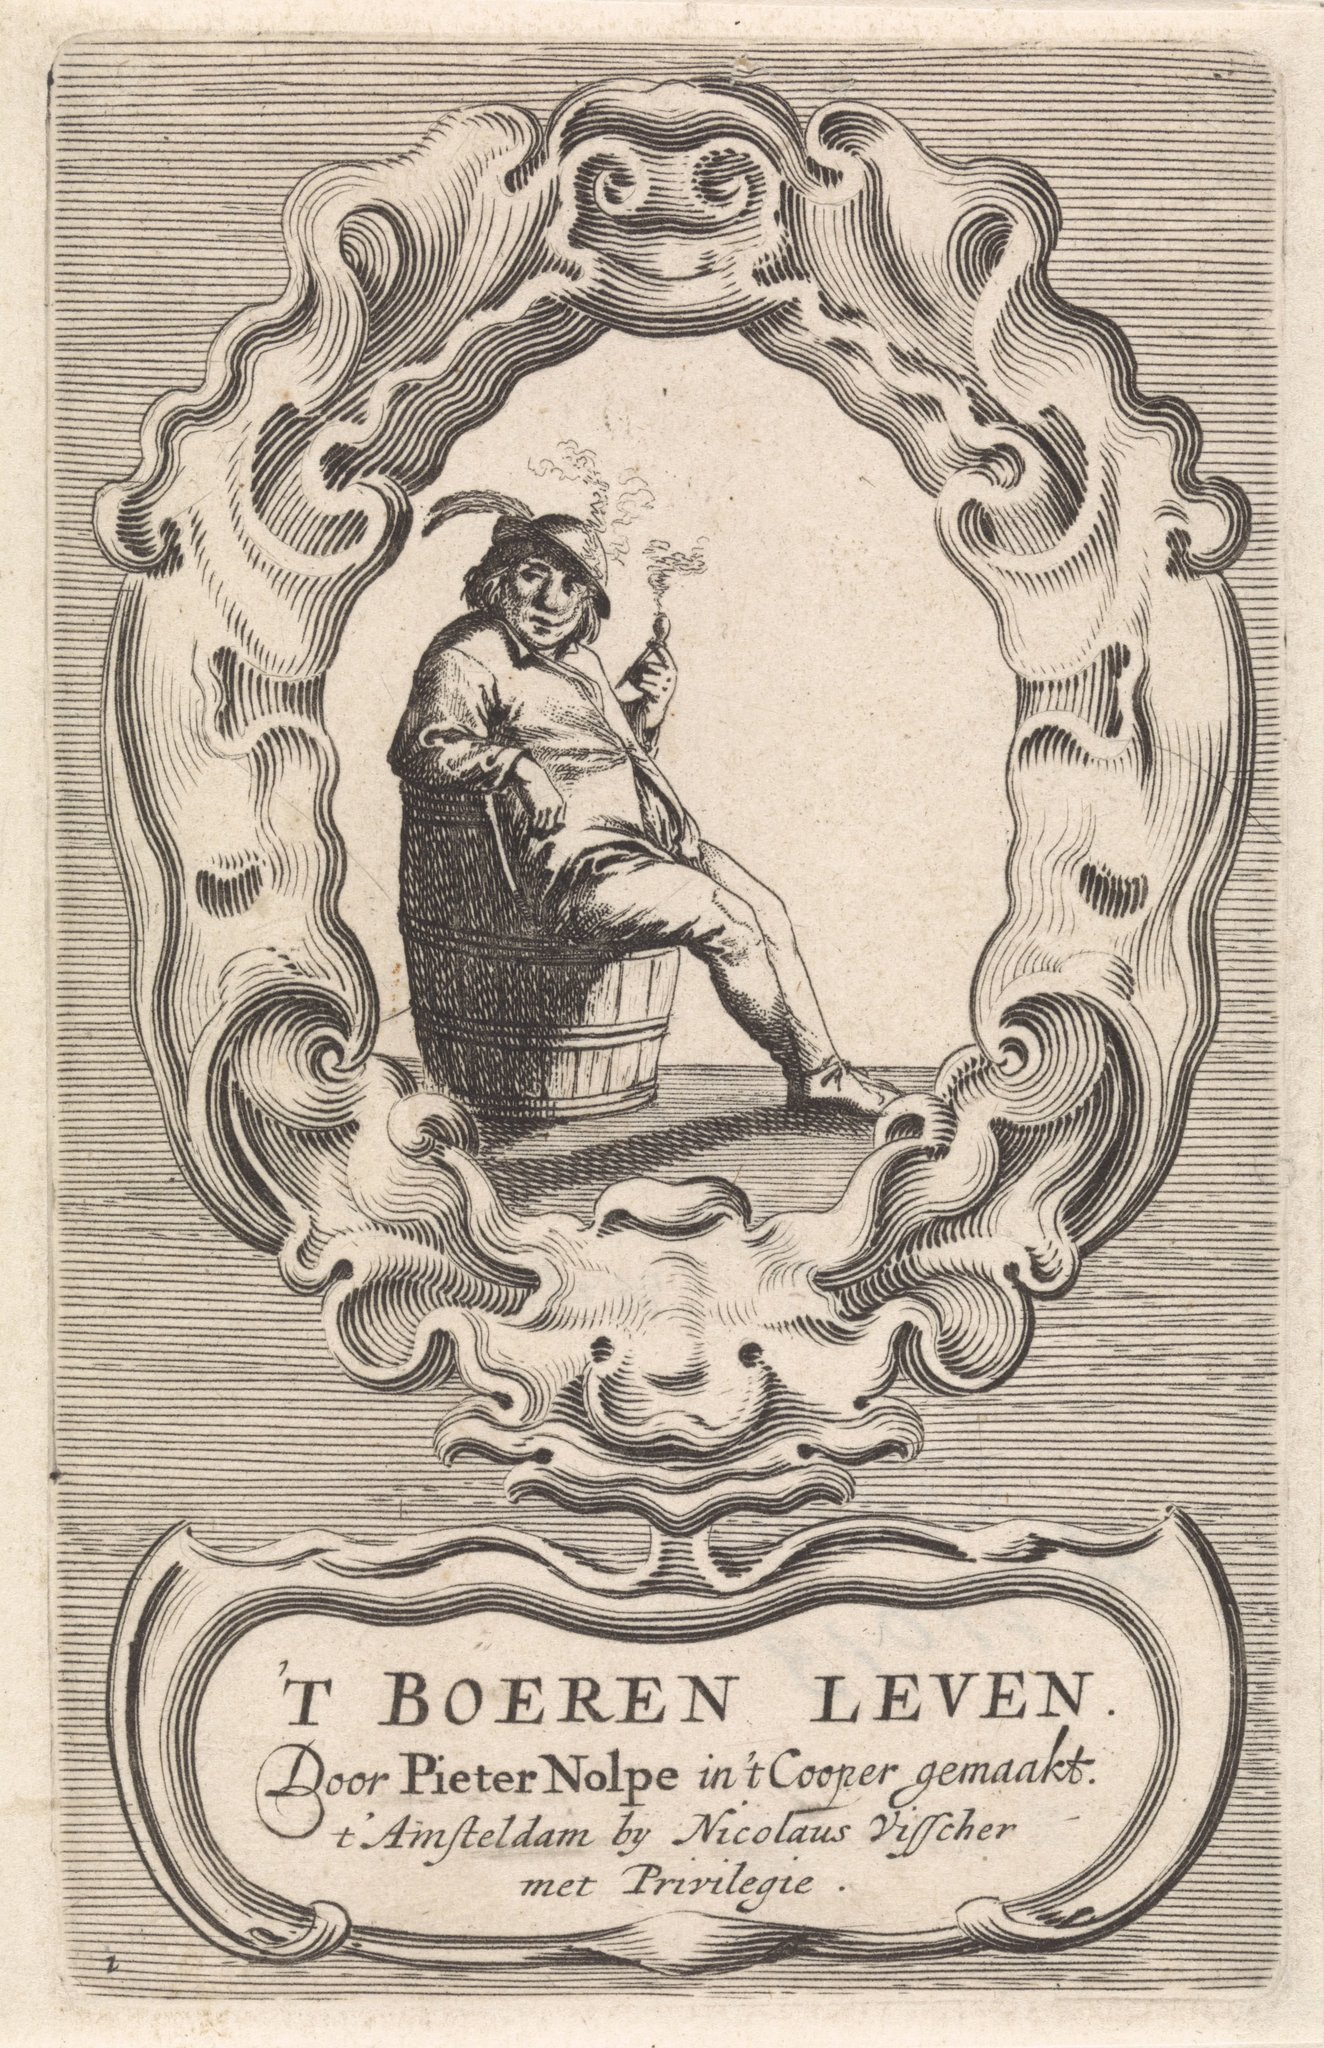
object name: print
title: Zittende pijprokende boer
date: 1633-1679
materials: paper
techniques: engraving, etching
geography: amsterdam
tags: wooden container: barrel, cask, bucket, pipe ~ tobacco, farmers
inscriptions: collector's mark: Lugt 2228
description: Een boer zit in een tot stoel omgebouwde ton, een hoed met een veer op het hoofd, waar hij zijn pijp rookt. De voorstelling is gevat in een ovale ornamentele lijst. Titelprent van een serie met scènes uit het boerenleven.